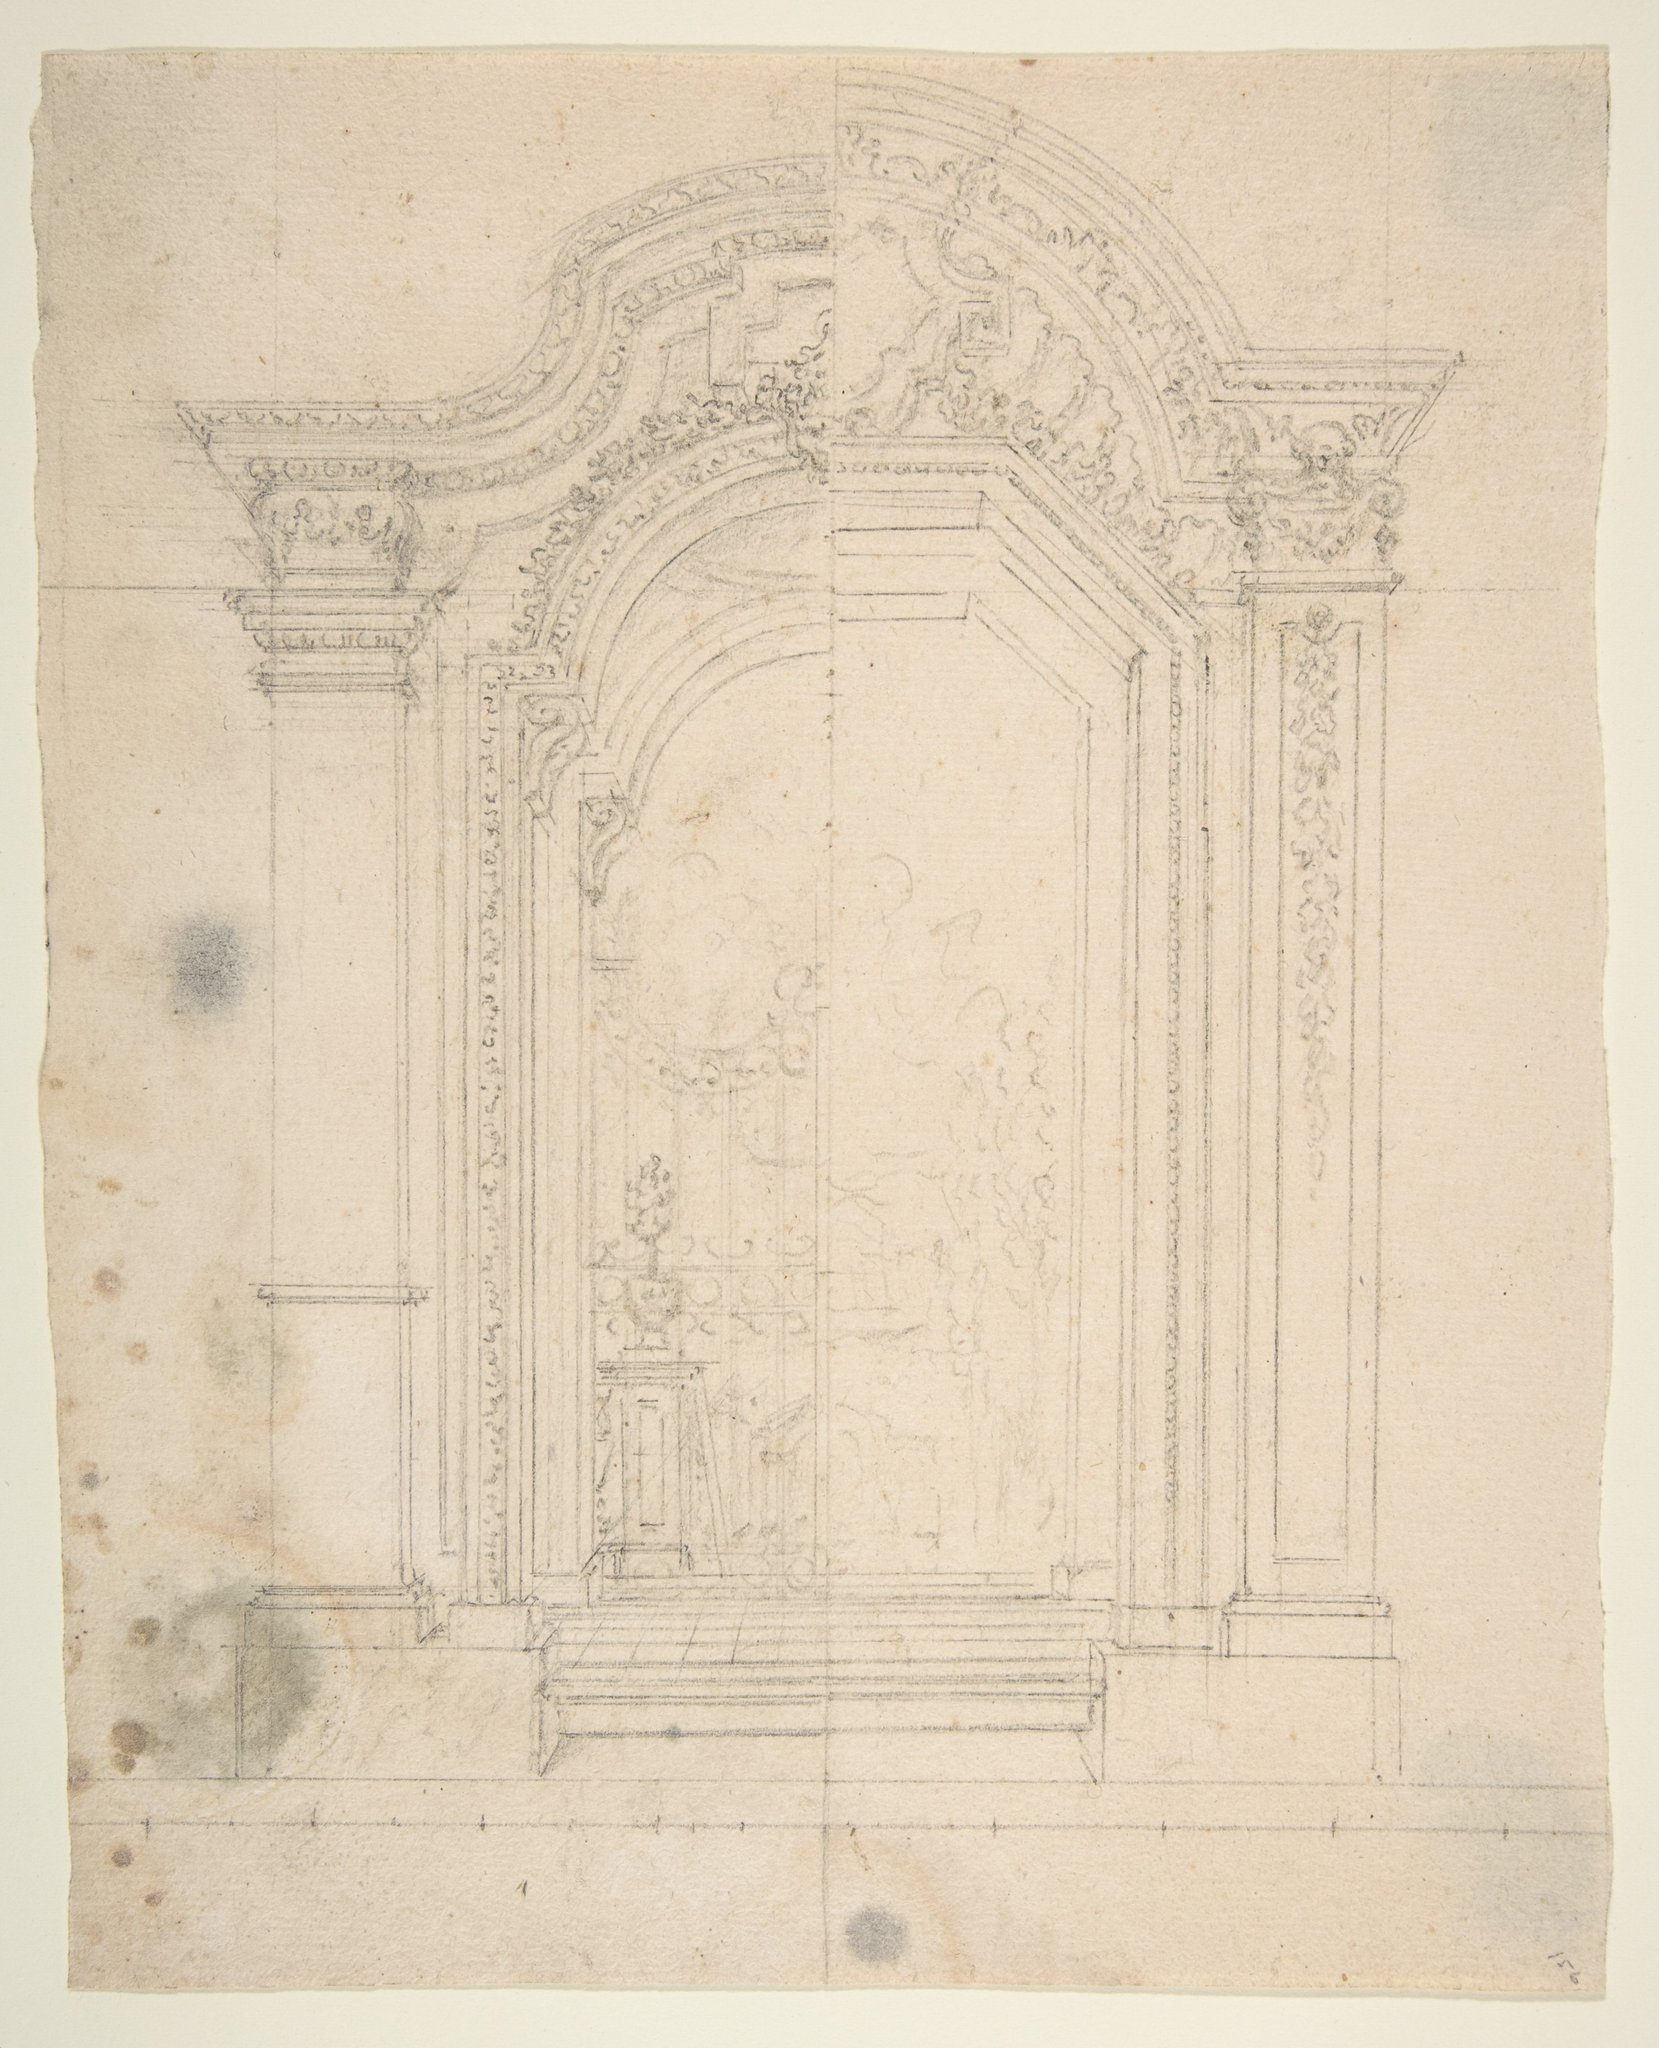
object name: drawing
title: Design for Stage Set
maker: leonardo marini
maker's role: artist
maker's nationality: italian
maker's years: 1730-1797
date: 1701-1800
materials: graphite, drawing material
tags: stage design